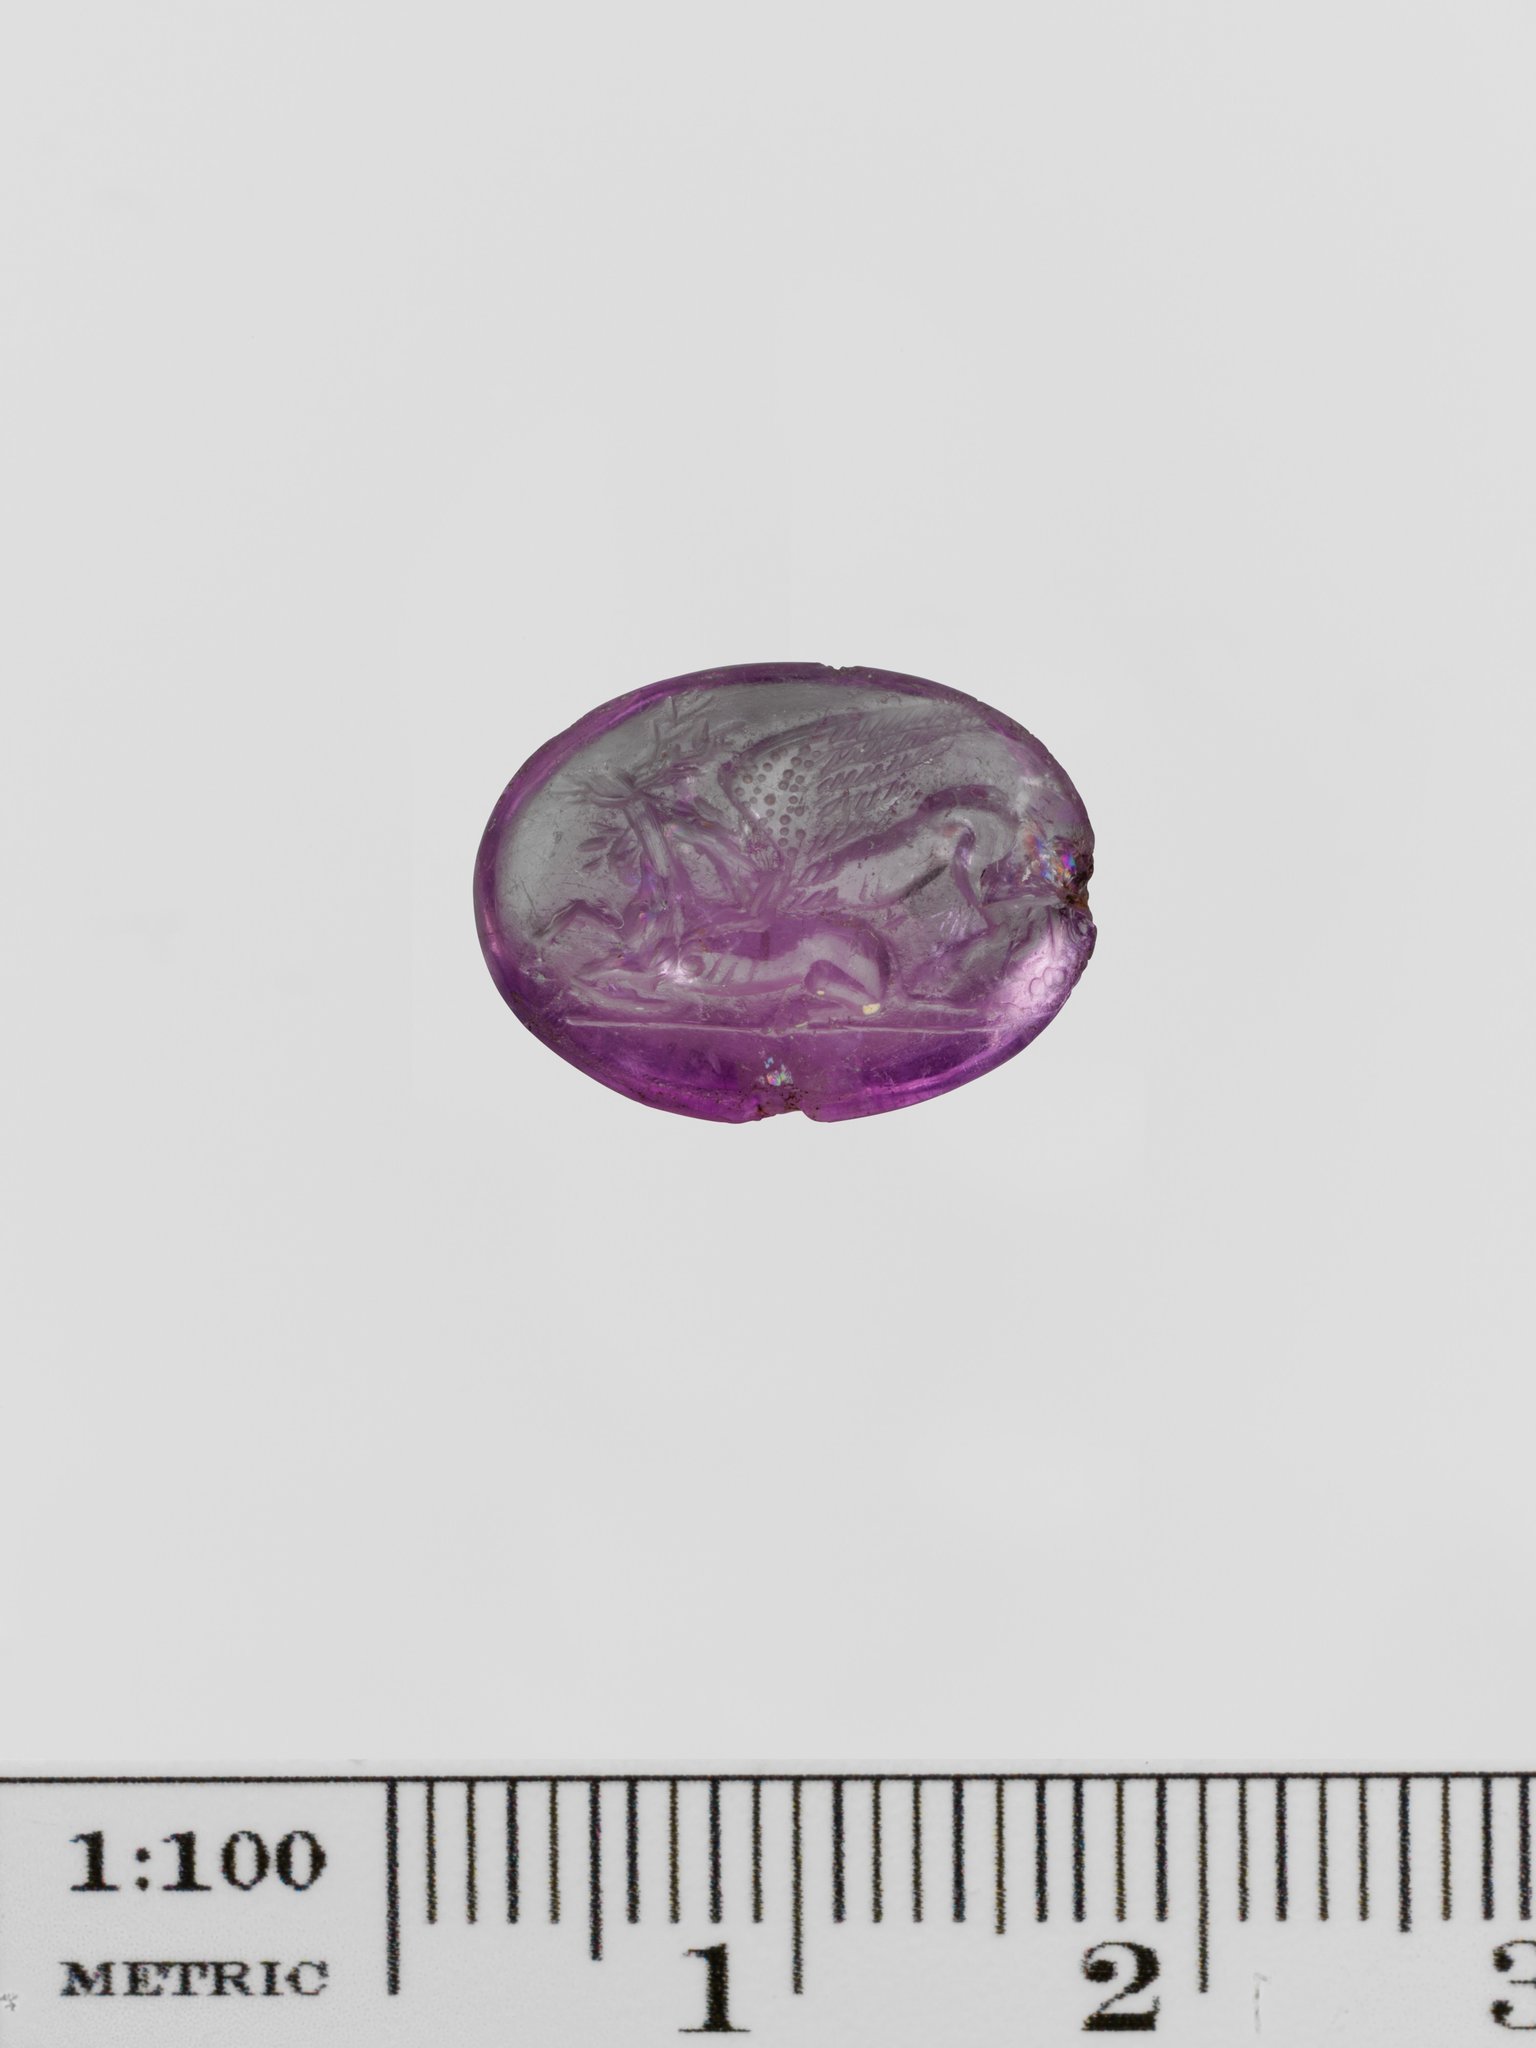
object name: intaglio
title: Amethyst ring stone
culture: greek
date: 400-301 BCE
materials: gemstone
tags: griffins,deer